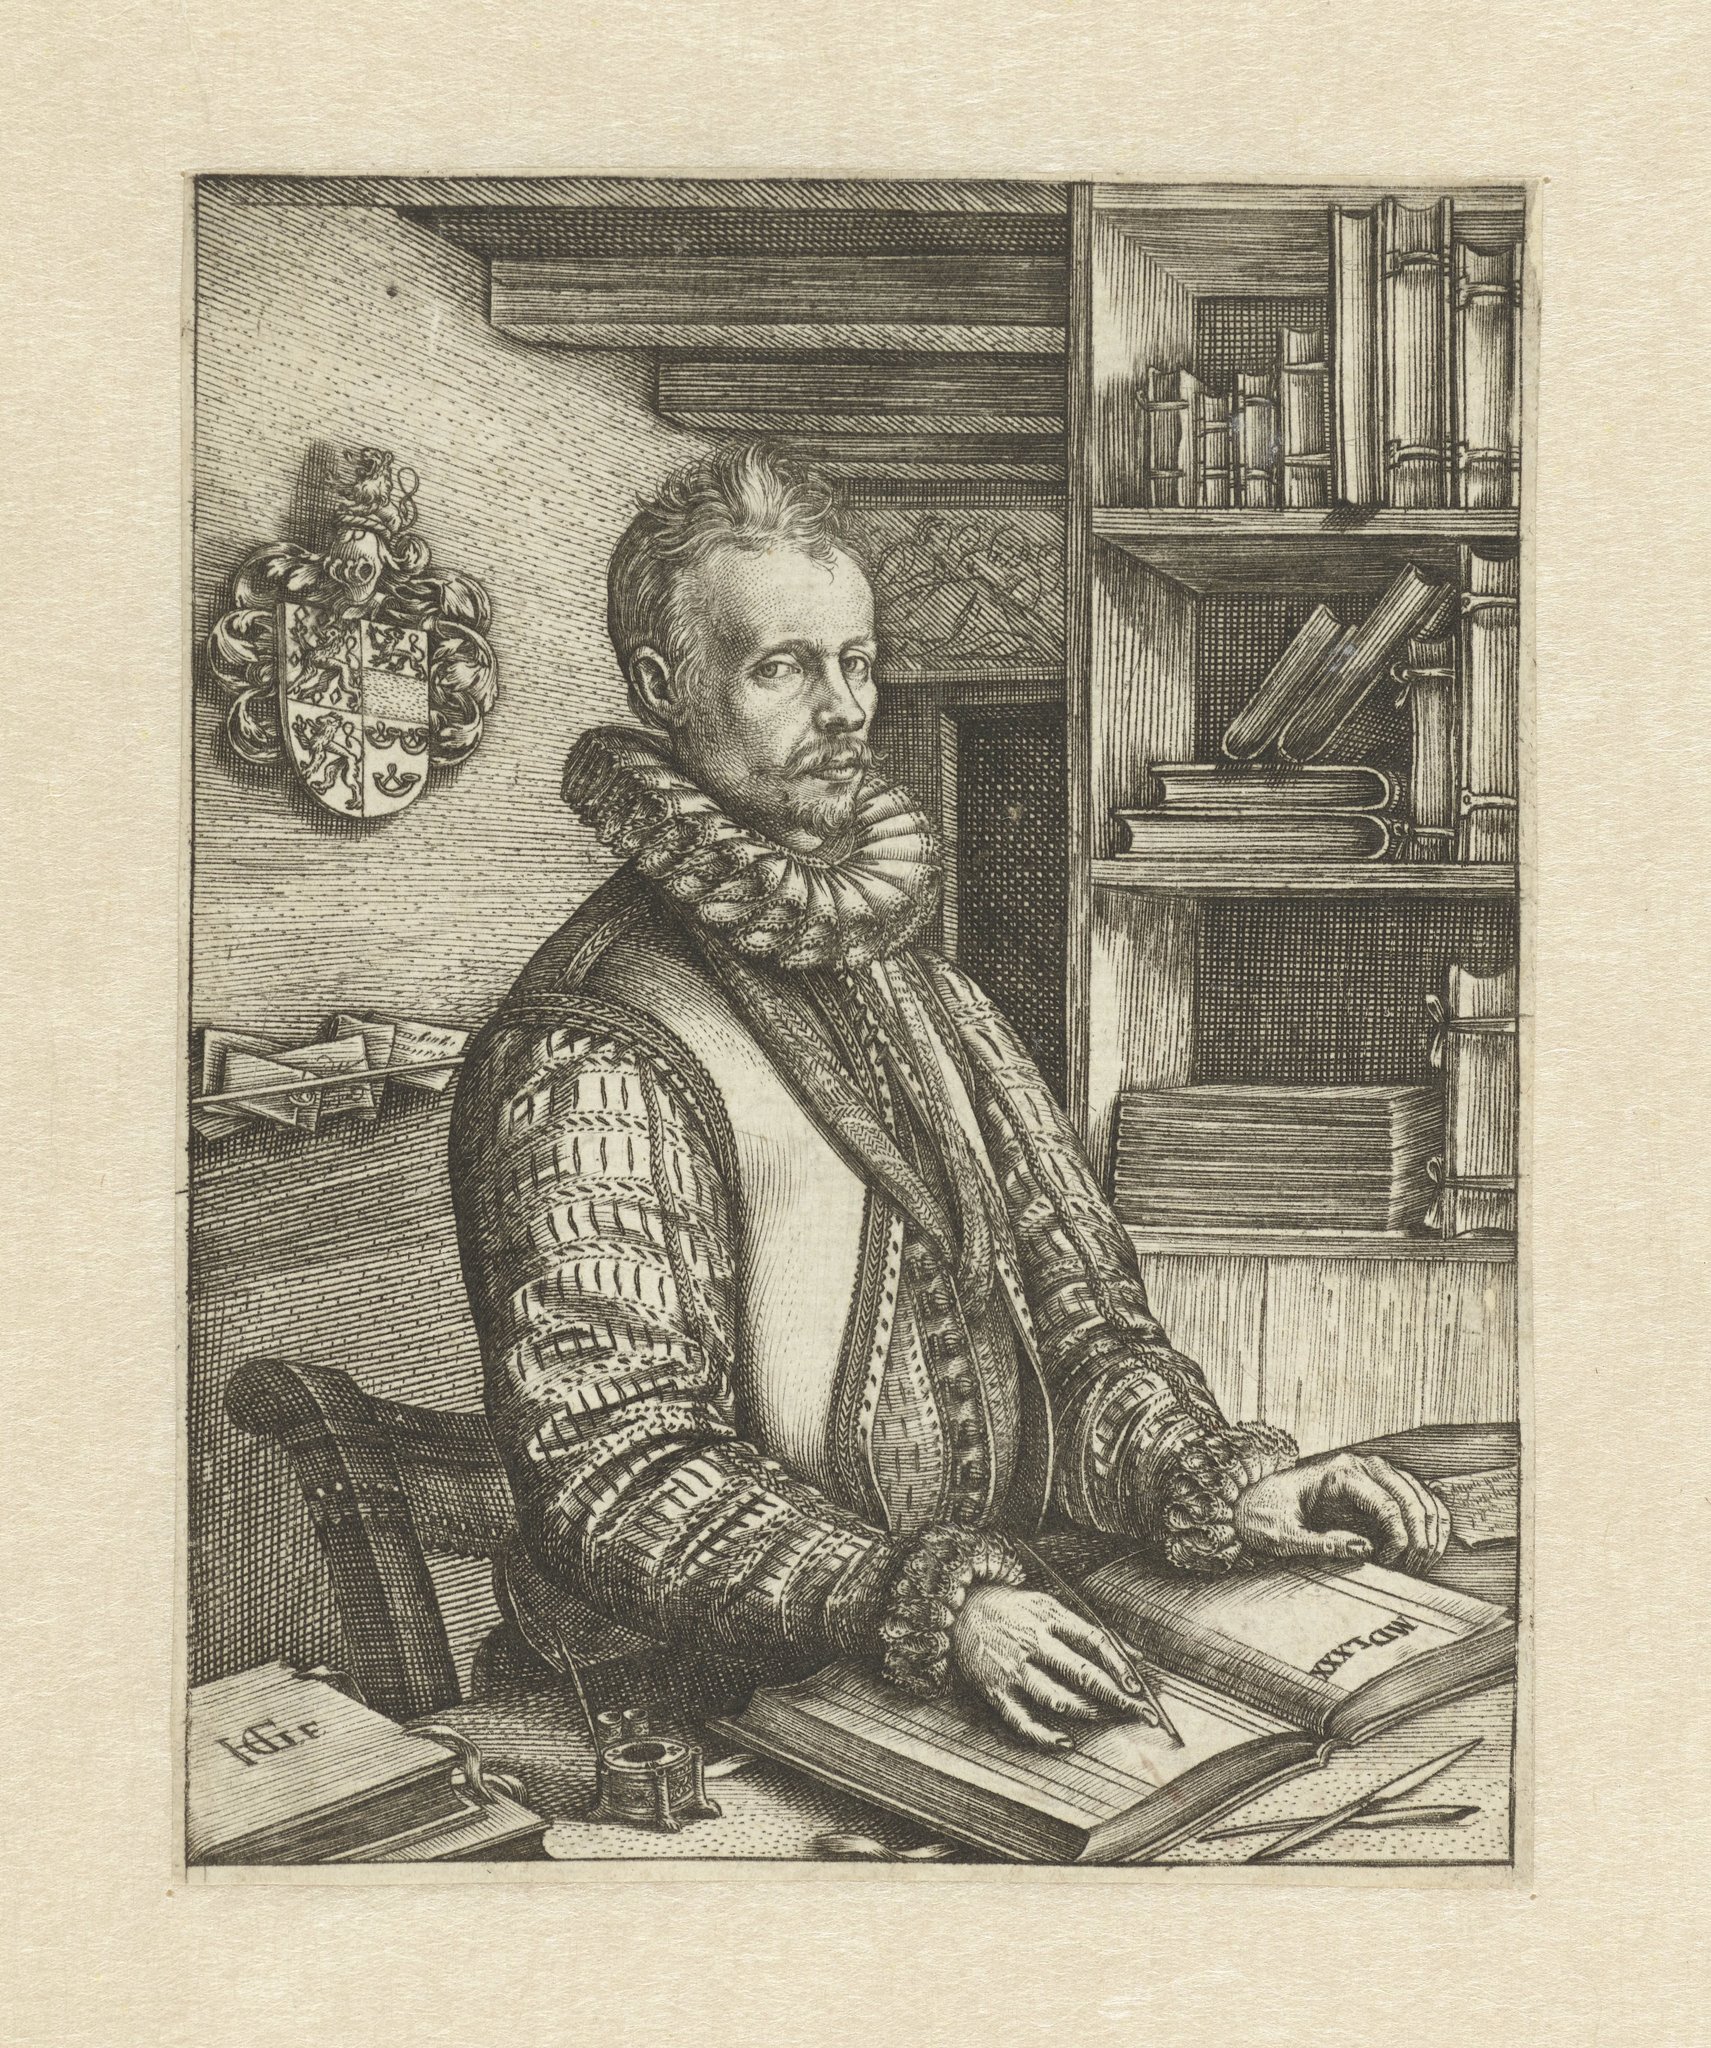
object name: print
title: Portret van Abraham Gorlaeus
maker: hendrick goltzius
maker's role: draughtsman, painter, print maker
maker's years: 1558-1617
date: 1580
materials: paper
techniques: engraving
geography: haarlem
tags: writing-table, writing-desk, scholar in his study, neck-gear ~ clothing (with name) (+ men's clothes), writing and letters (+ scholar, scientist (at work)), historical persons, study; 'studiolo'; library, book, clothing for the upper part of the body (doublet) (+ men's clothes), sleeves (+ men's clothes), armorial bearing, heraldry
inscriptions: collector's mark: Lugt 240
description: Abraham Gorlaeus (van Goorle) (1549-1609), verzamelaar van antieke munten en gemmen, zittend aan een tafel, schrijvend in een boek. Een boekenkast tegen de achterwand. Linksboven zijn familiewapen. In Oud Holland (zie documentatie) is gesteld dat de geportretteerde niet Abraham, maar diens broer David (1550-1612) is.